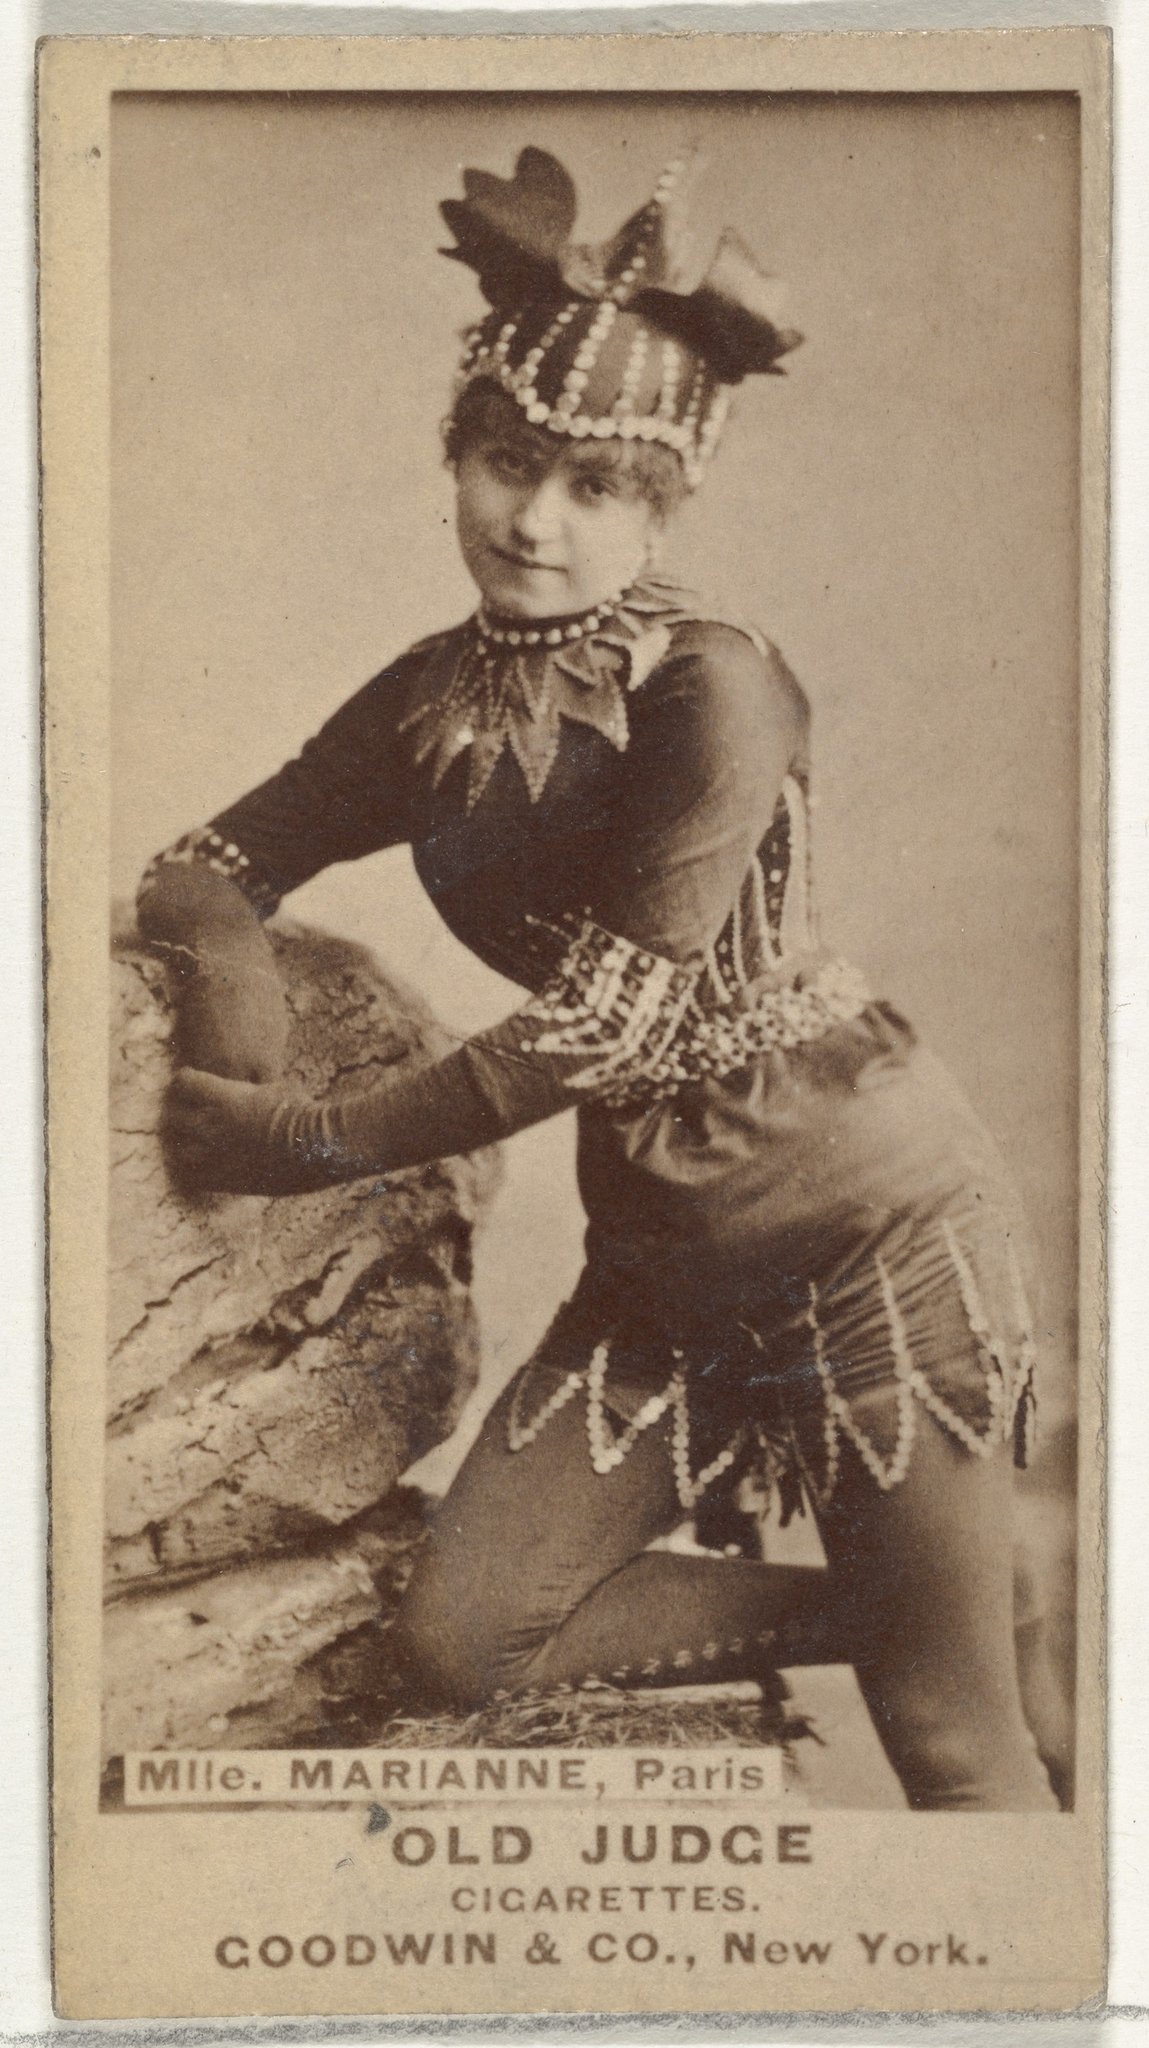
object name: photograph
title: Mlle. Marianne, Paris, from the Actors and Actresses series (N171) for Old Judge Cigarettes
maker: goodwin & company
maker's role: publisher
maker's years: 1850-1950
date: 1886-1890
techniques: albumen silver print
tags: portraits,women,actresses